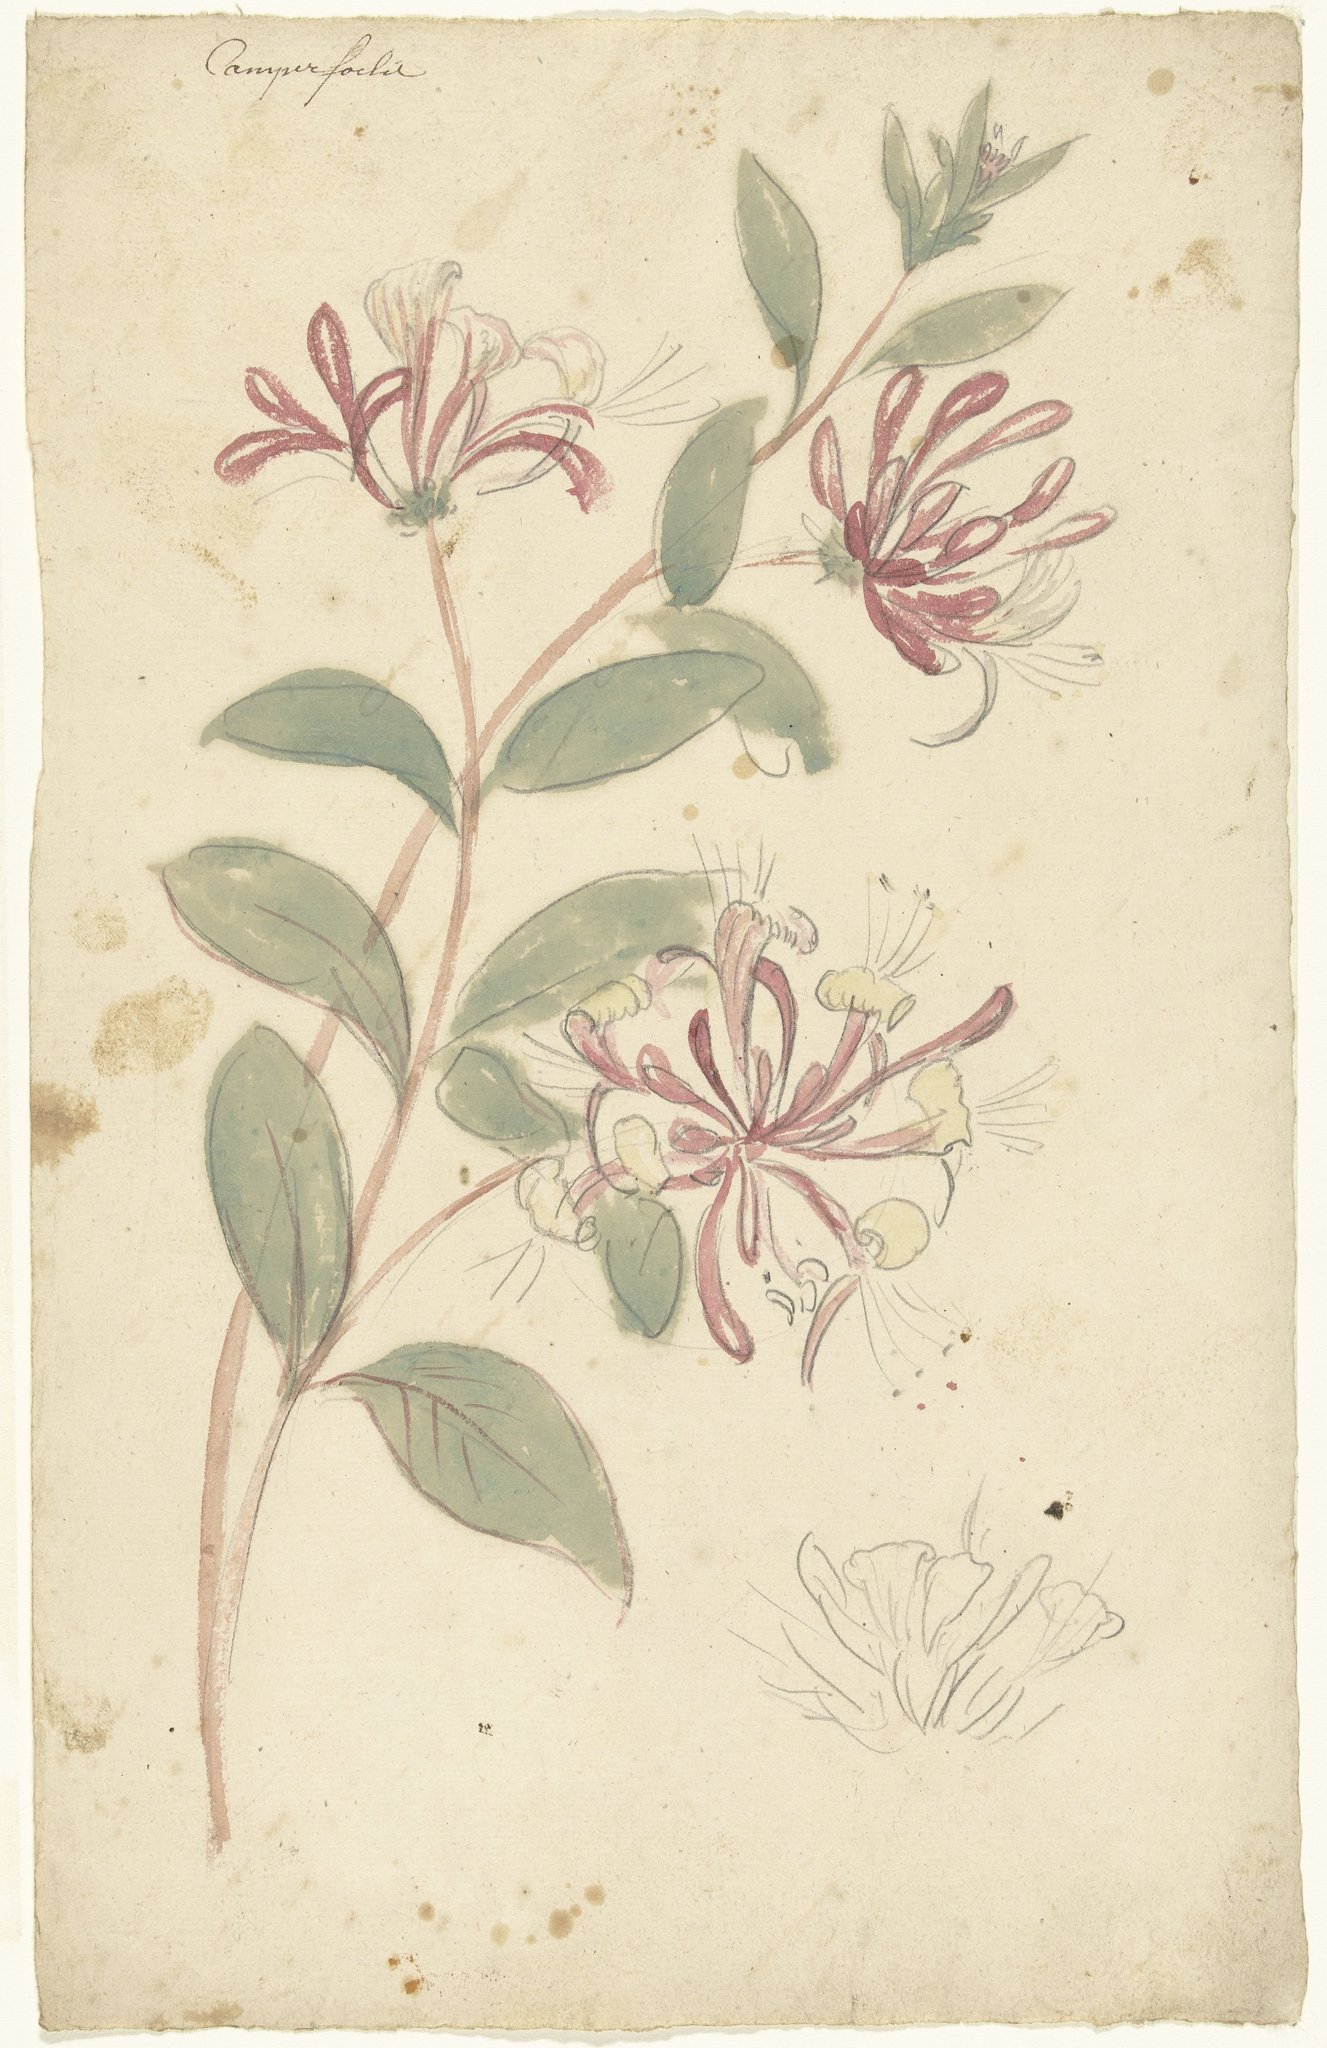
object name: watercolor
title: Kamperfoelie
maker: elias van nijmegen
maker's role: draughtsman, painter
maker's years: 1667-1755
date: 1677-1755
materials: paper, pencil, watercolor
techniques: brush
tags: flowers: honeysuckle